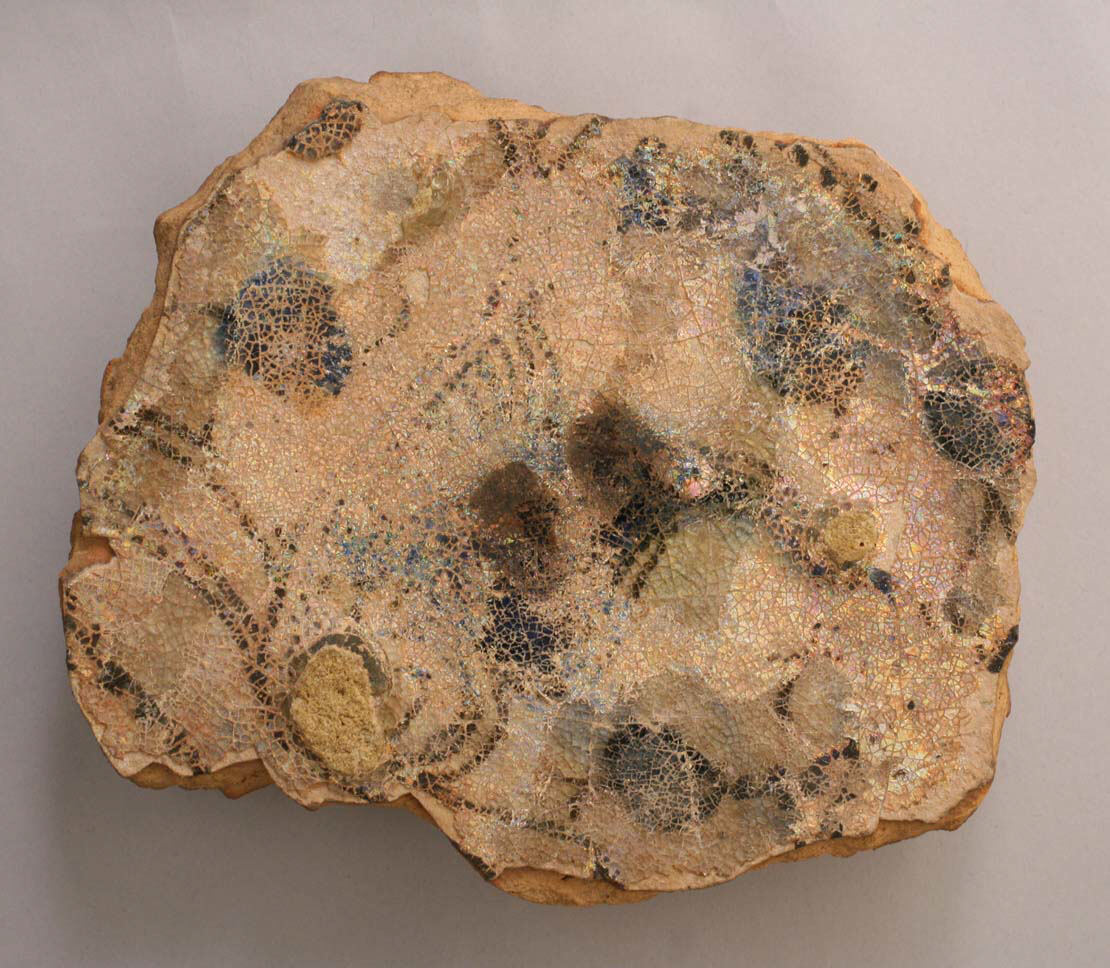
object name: fragment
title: Ceramic Fragment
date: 1301-1400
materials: stonepaste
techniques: painting, underglaze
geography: egypt